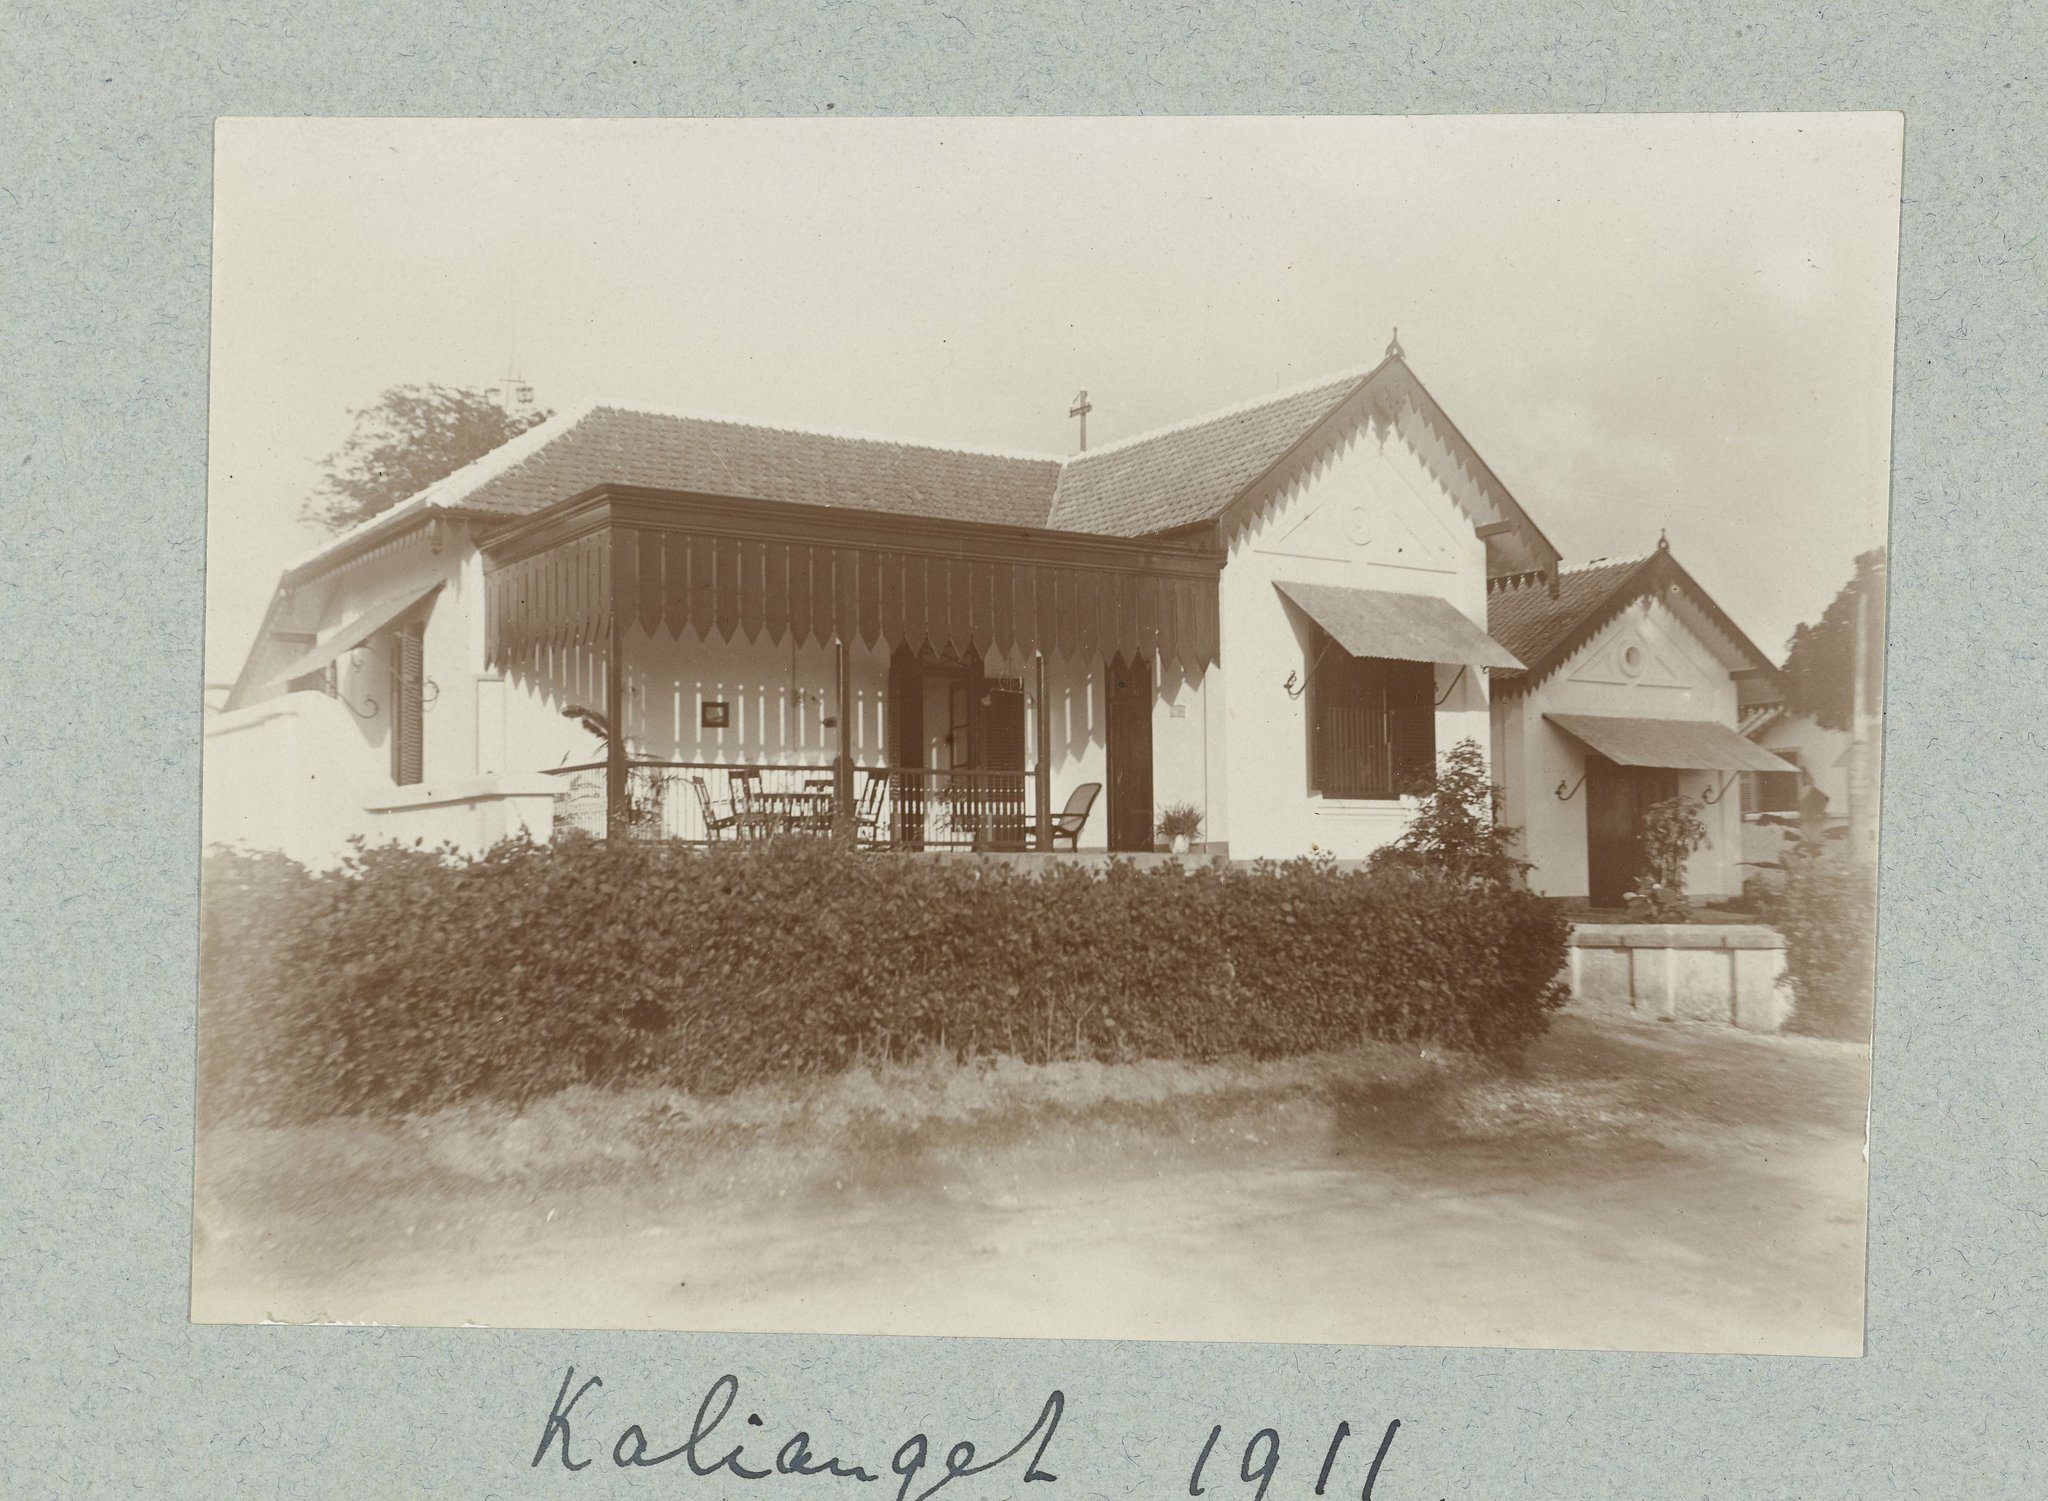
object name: photograph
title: Photographieën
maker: frits freerks fontein fz.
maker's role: fotograaf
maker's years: 1882-1928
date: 1910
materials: cardboard, paper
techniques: gelatin silver print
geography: netherlands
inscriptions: caption: ‘Kalianget 1911’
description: De mannen dragen witte tropenuniformen waarvan een man met tropenhelm, twee andere mannen dragen een strooien hoed, de vrouwen dragen witte jurken of batik rokken met witte hes. Foto uit album 'Photographieën".